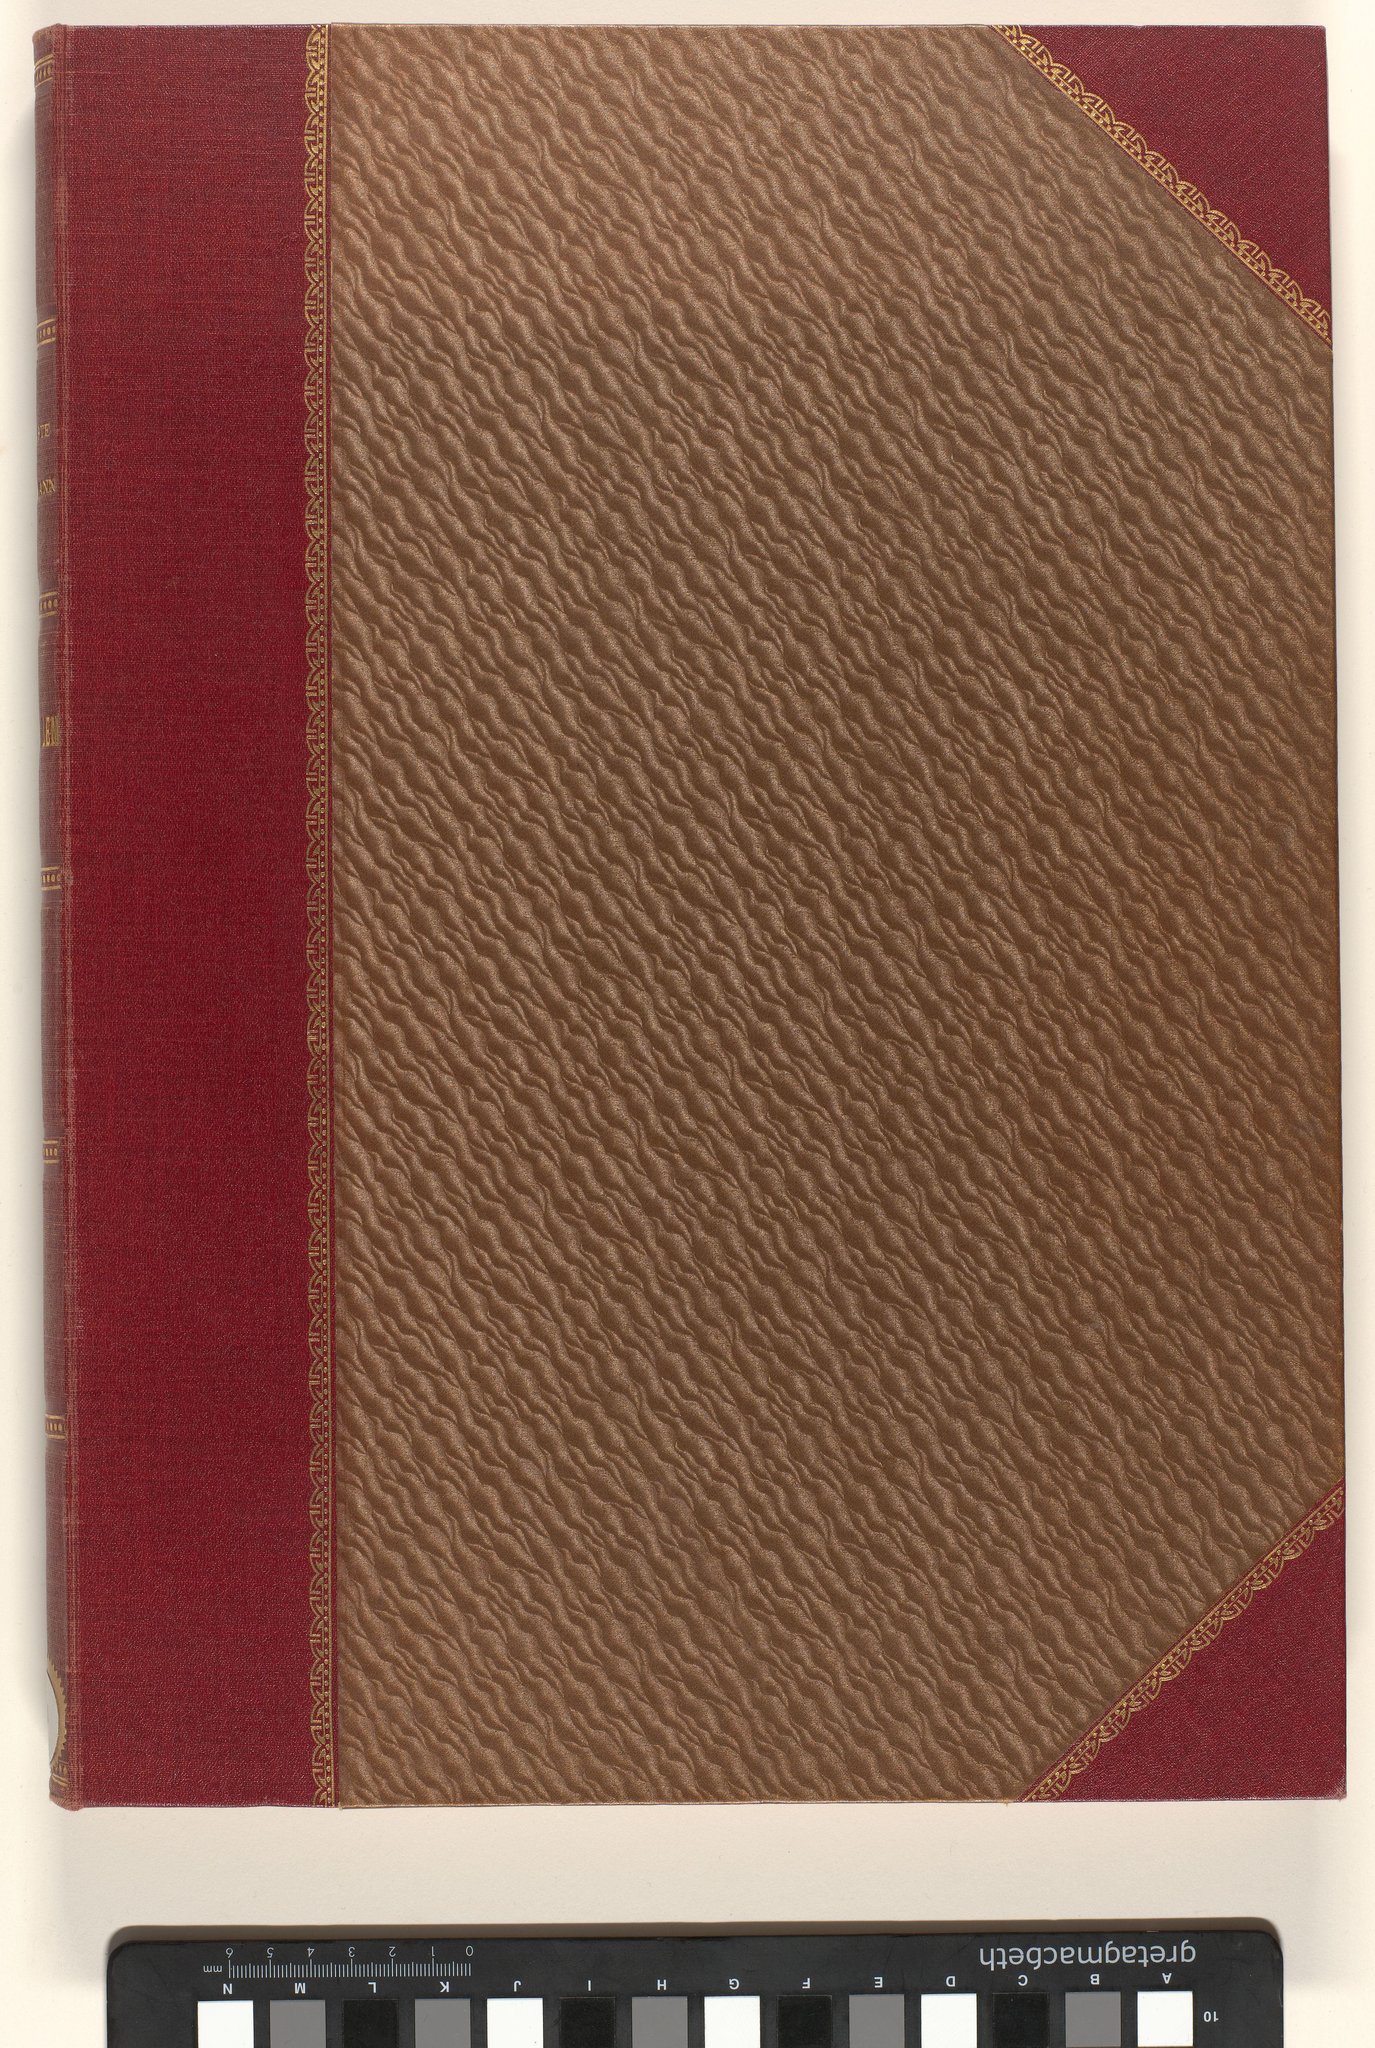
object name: book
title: Jérusalem. Étude et reproduction photographique des monuments de la ville sainte depuis l'époque judaïque jusqu'à nos jours - planches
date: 1856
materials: cardboard, linen, paper, silk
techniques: letterpress printing, salted paper print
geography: paris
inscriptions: inscription: ‘God. 109’, collector's mark: ‘Legaat/ Godefroy/ No 109’